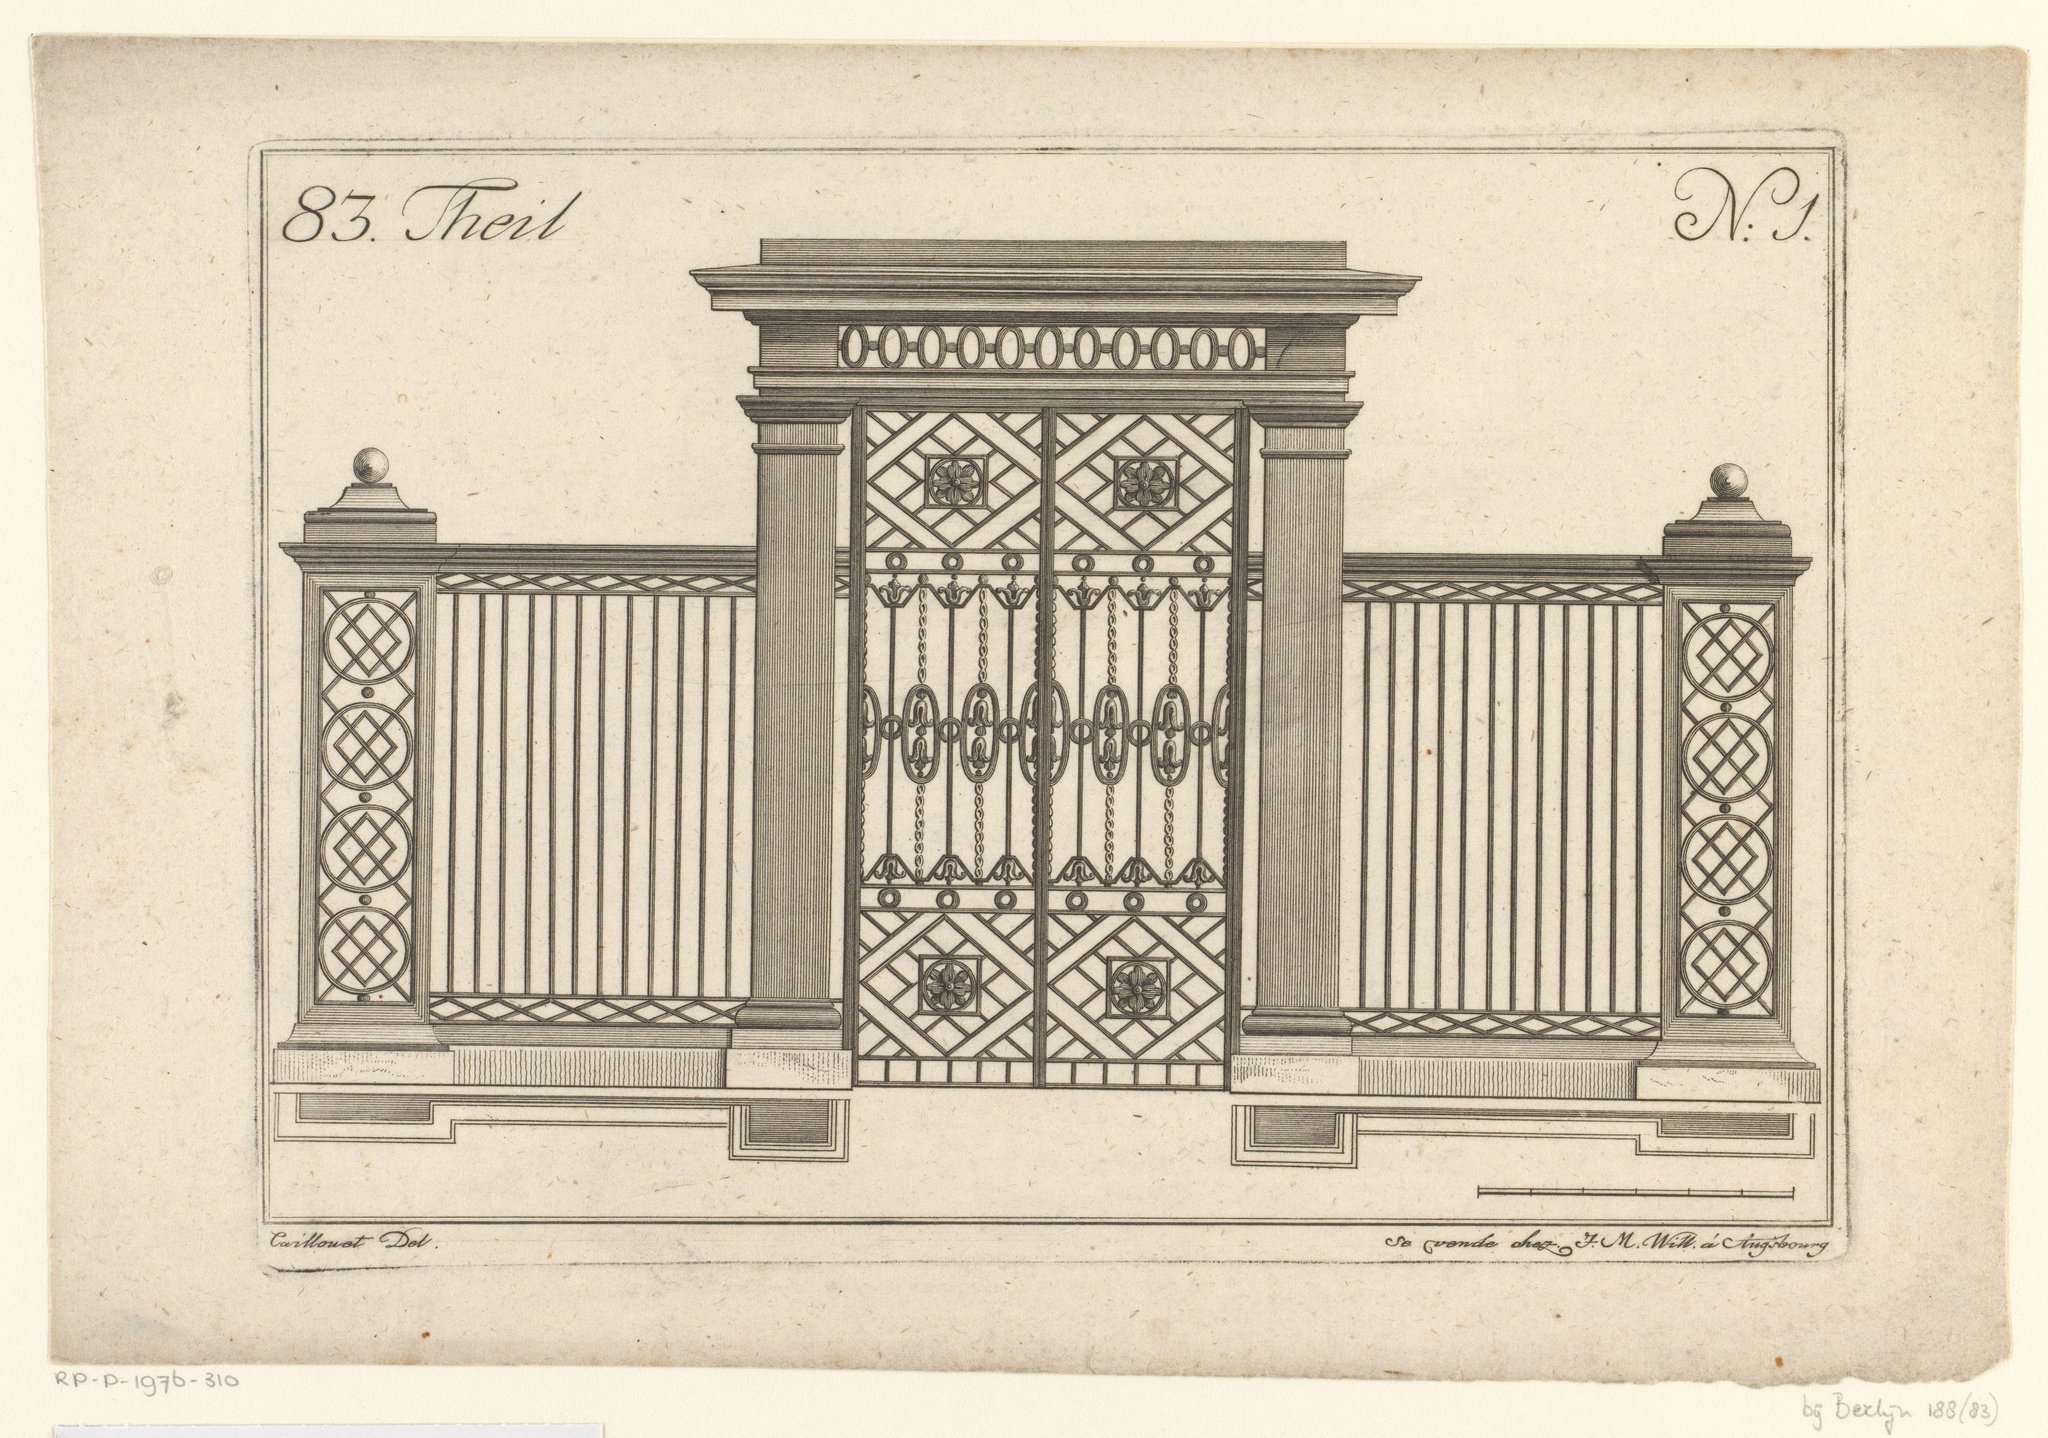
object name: print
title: Poort met hekwerk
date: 1737-1806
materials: paper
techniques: etching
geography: augsburg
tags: welding (industrial process), fence, wall, paling, gate, entrance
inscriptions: collector's mark: Lugt 2228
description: Een poort met smeedijzeren hekwerk met bloemmotieven.